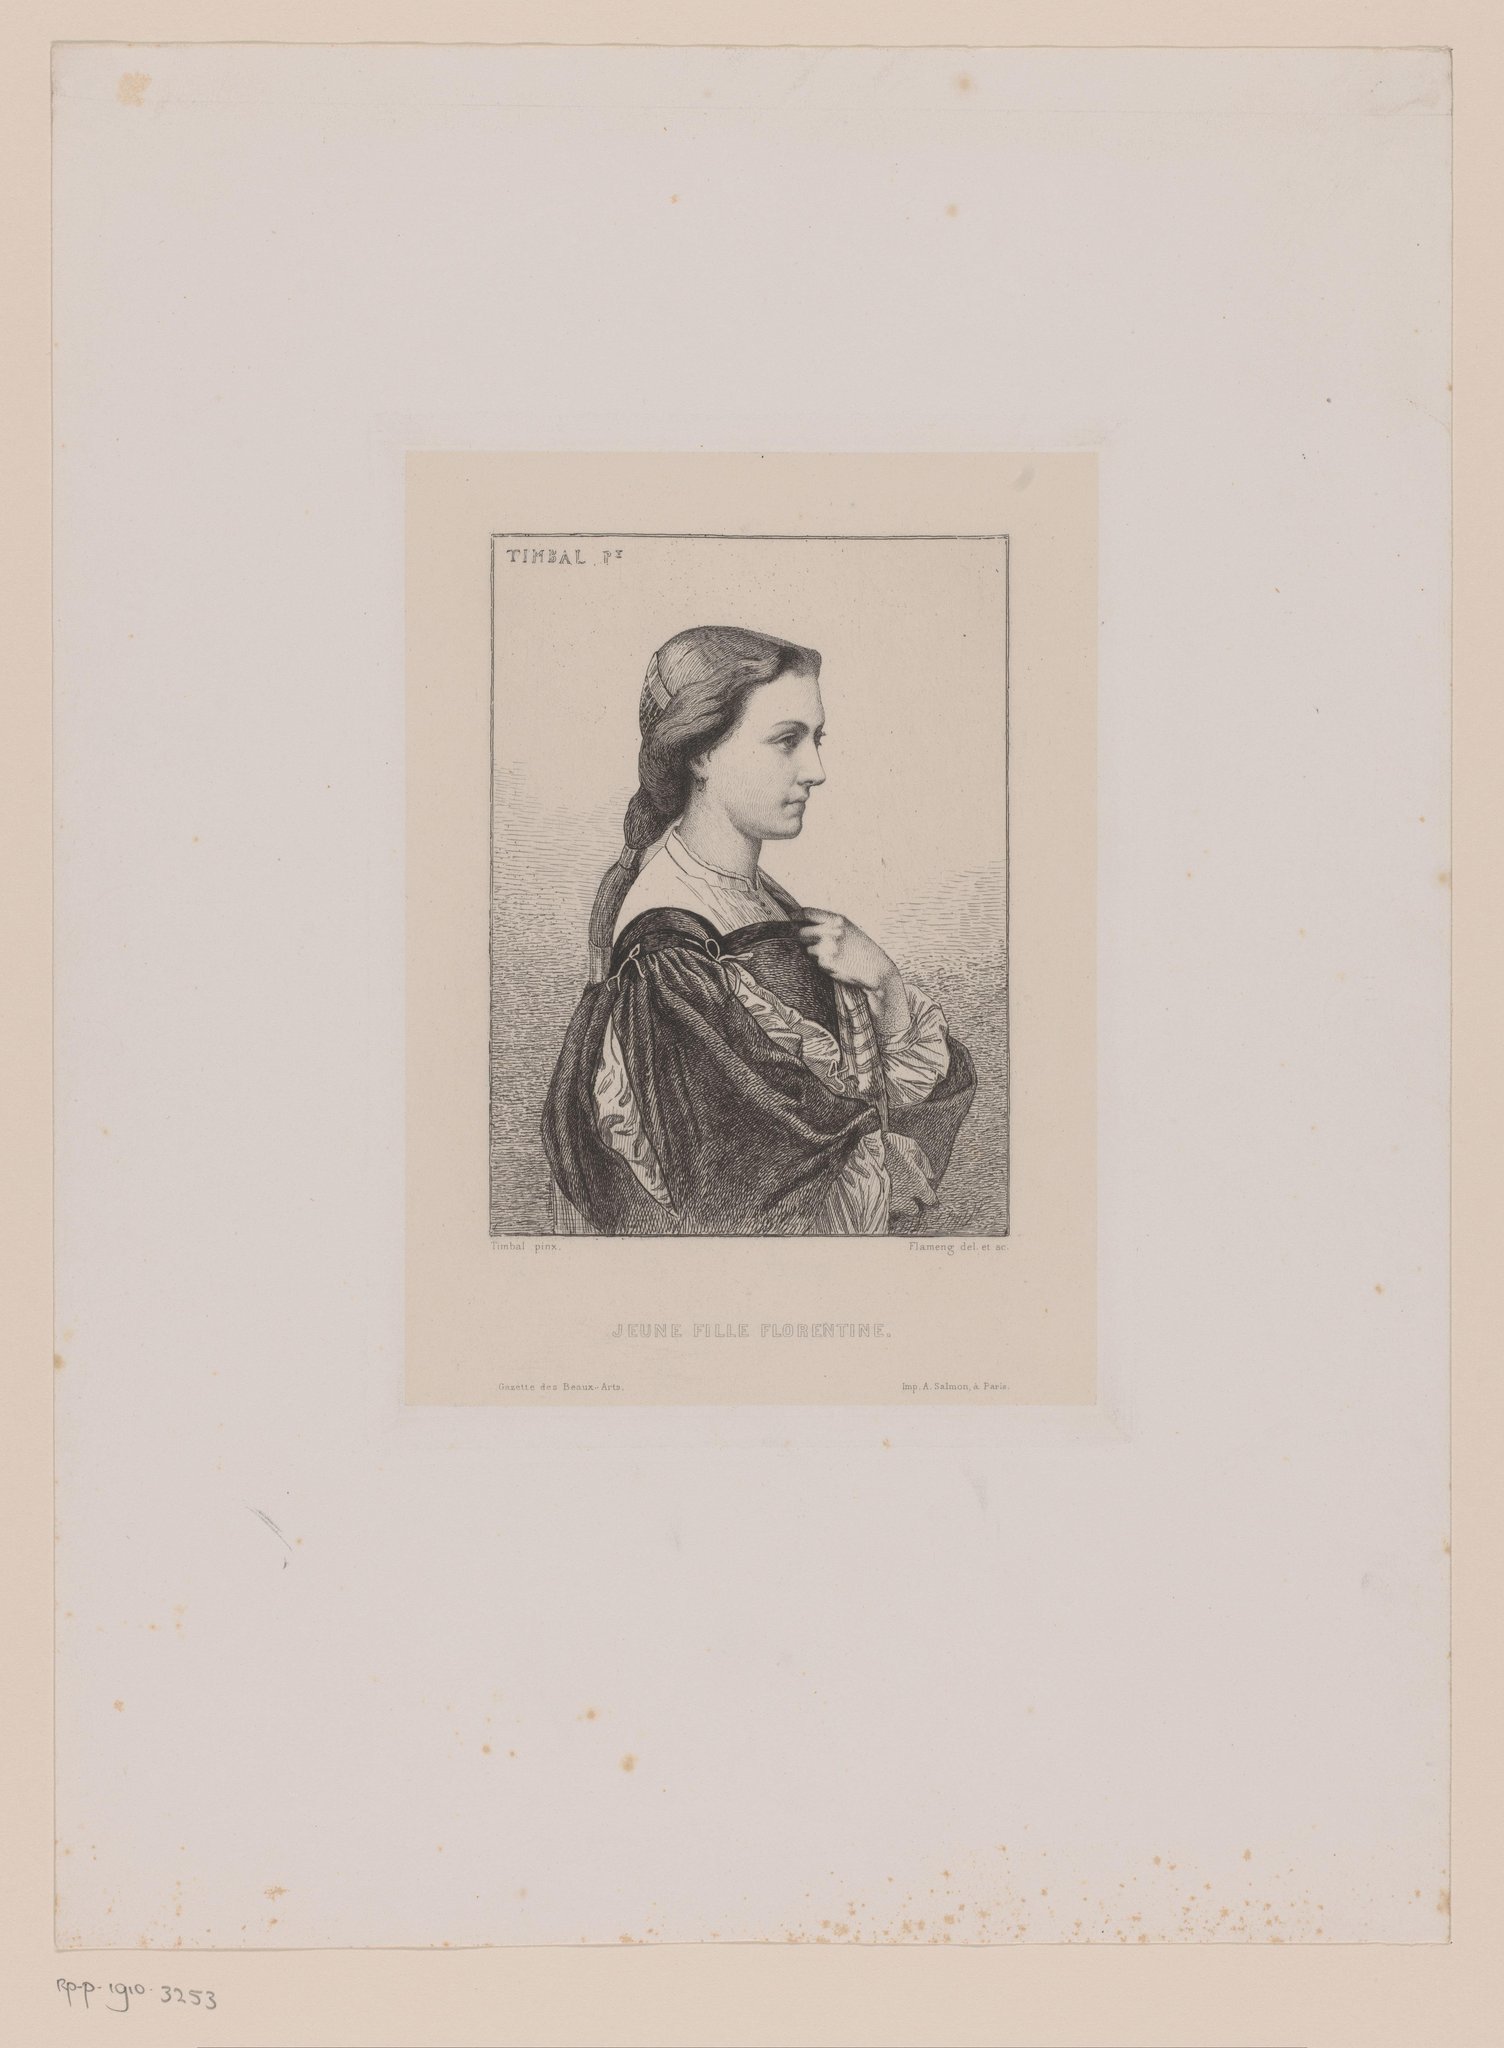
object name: print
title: Jonge vrouw uit Florence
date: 1863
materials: paper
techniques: etching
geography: paris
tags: anonymous historical person portrayed - bb - woman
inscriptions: collector's mark: Lugt 2228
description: Prent uit: Gazette des beaux-arts (1863), dl. 2, p. 35.